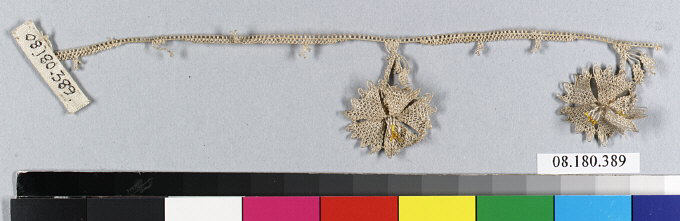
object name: fragment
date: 1801-1900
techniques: lace